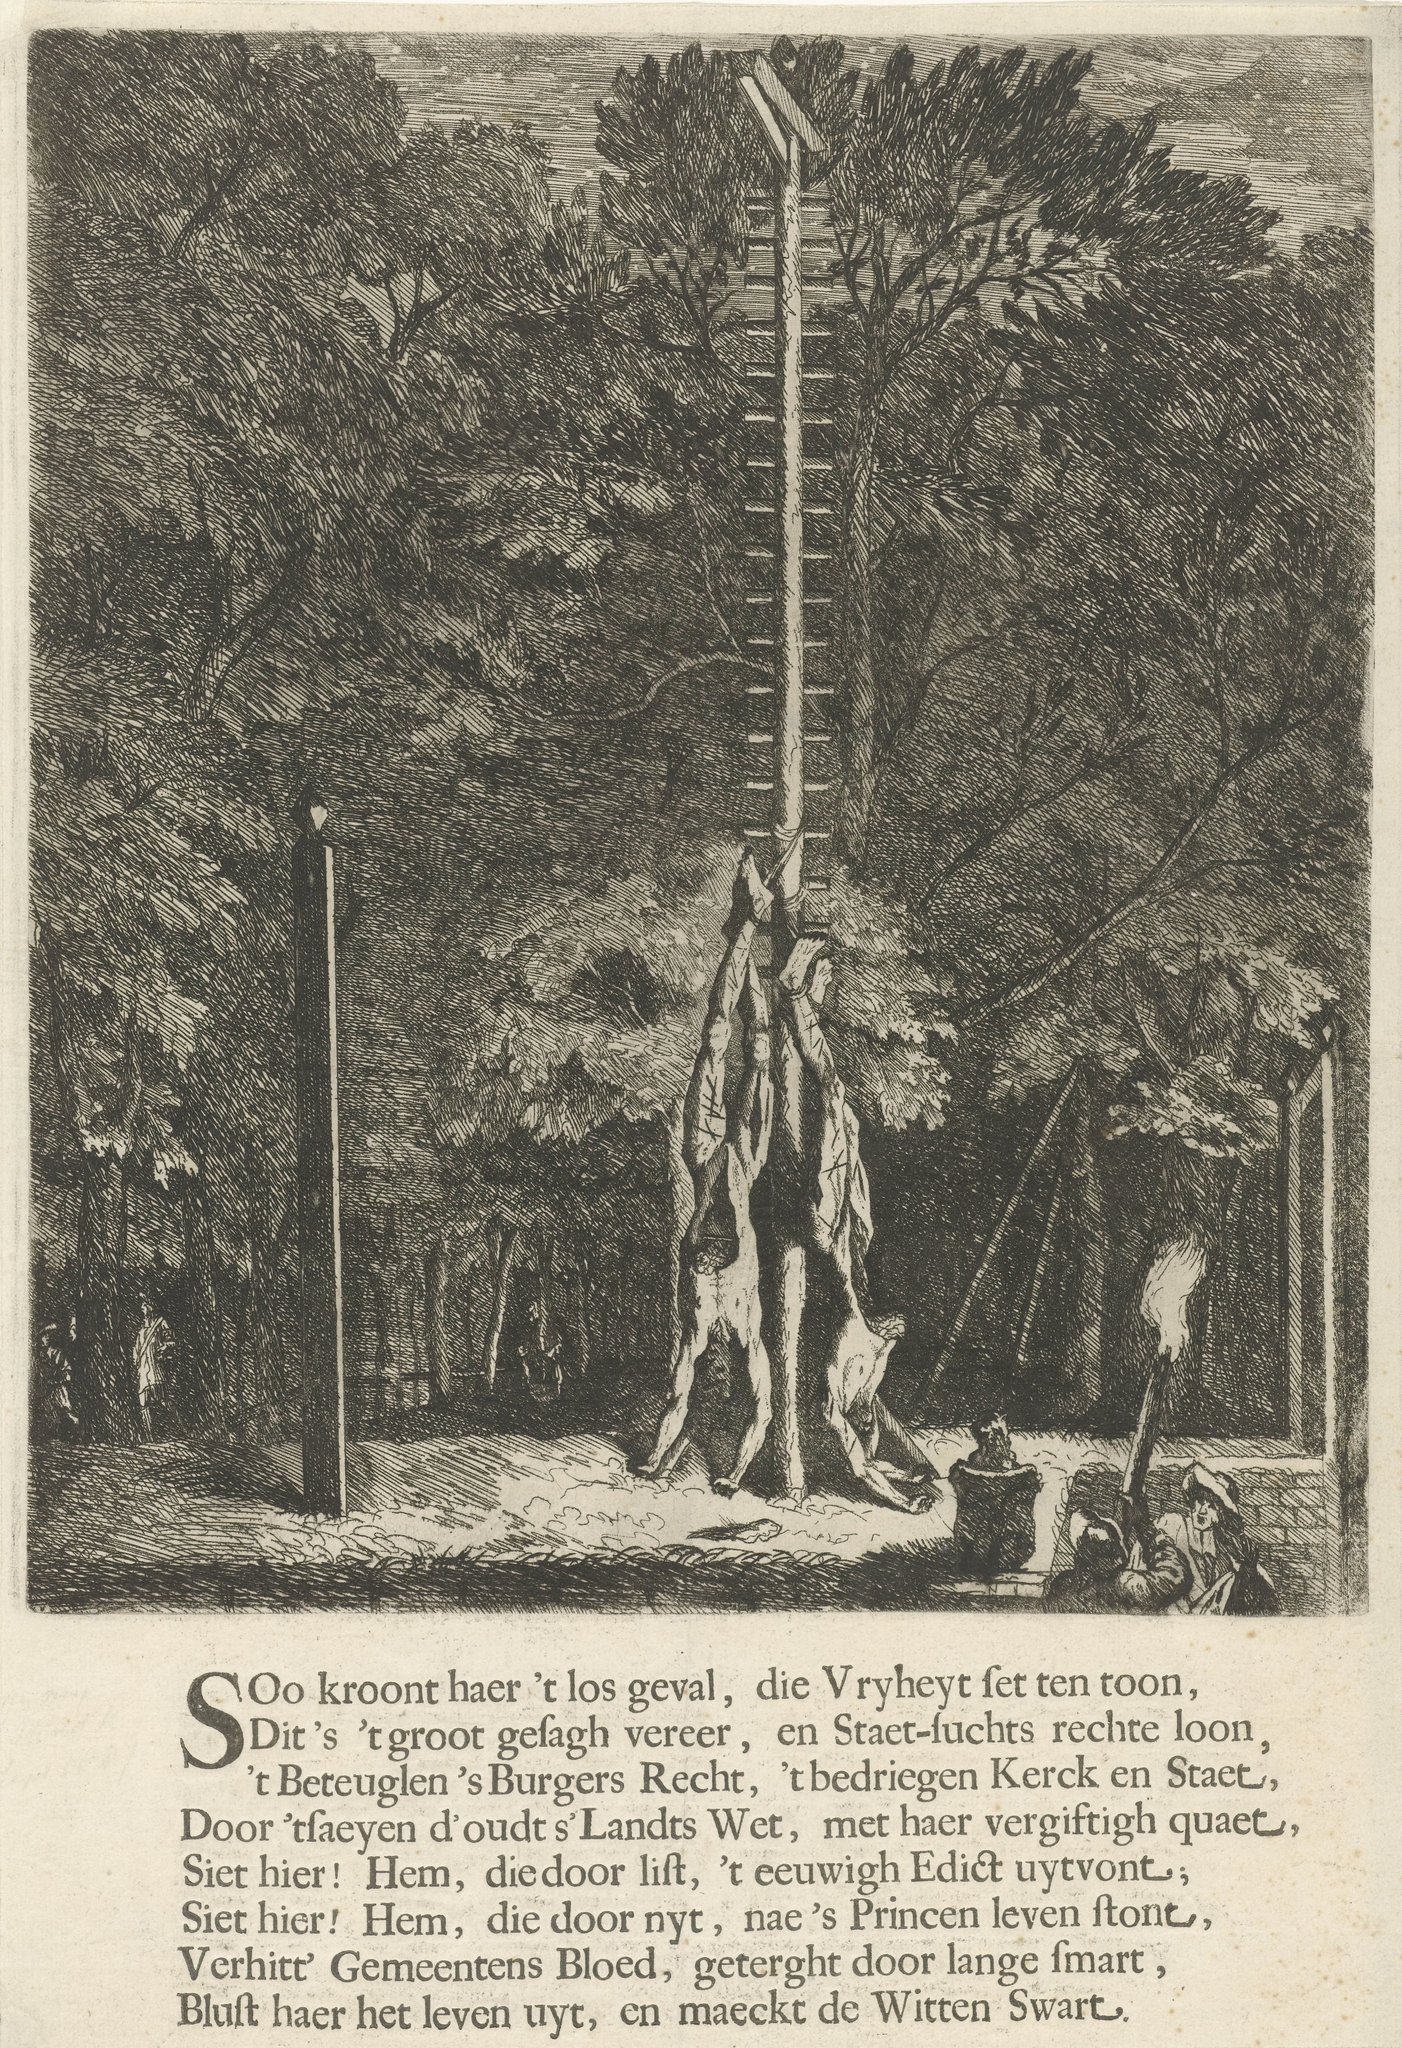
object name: print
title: De verminkte lichamen van de gebroeders De Witt hangend aan de wip, 1672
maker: roelant roghman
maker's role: draughtsman, painter, print maker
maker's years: 1627-1692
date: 1672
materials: paper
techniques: engraving, etching, letterpress printing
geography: amsterdam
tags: dordrecht, the hague, cornelis de witt, politician, johan de witt, mutilation of the corpse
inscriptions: collector's mark: Lugt 2228a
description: Nachtvoorstelling van de verminkte lichamen van Johan en Cornelis de Witt, hangend aan de wip, tegen een achtergrond van de bomen bij de Vijverberg, 20 augustus 1672. Rechts op de voorgrond twee figuren met een brandende fakkel. Onder de voorstelling een vers van acht regels tegen de gebroeders De Witt.